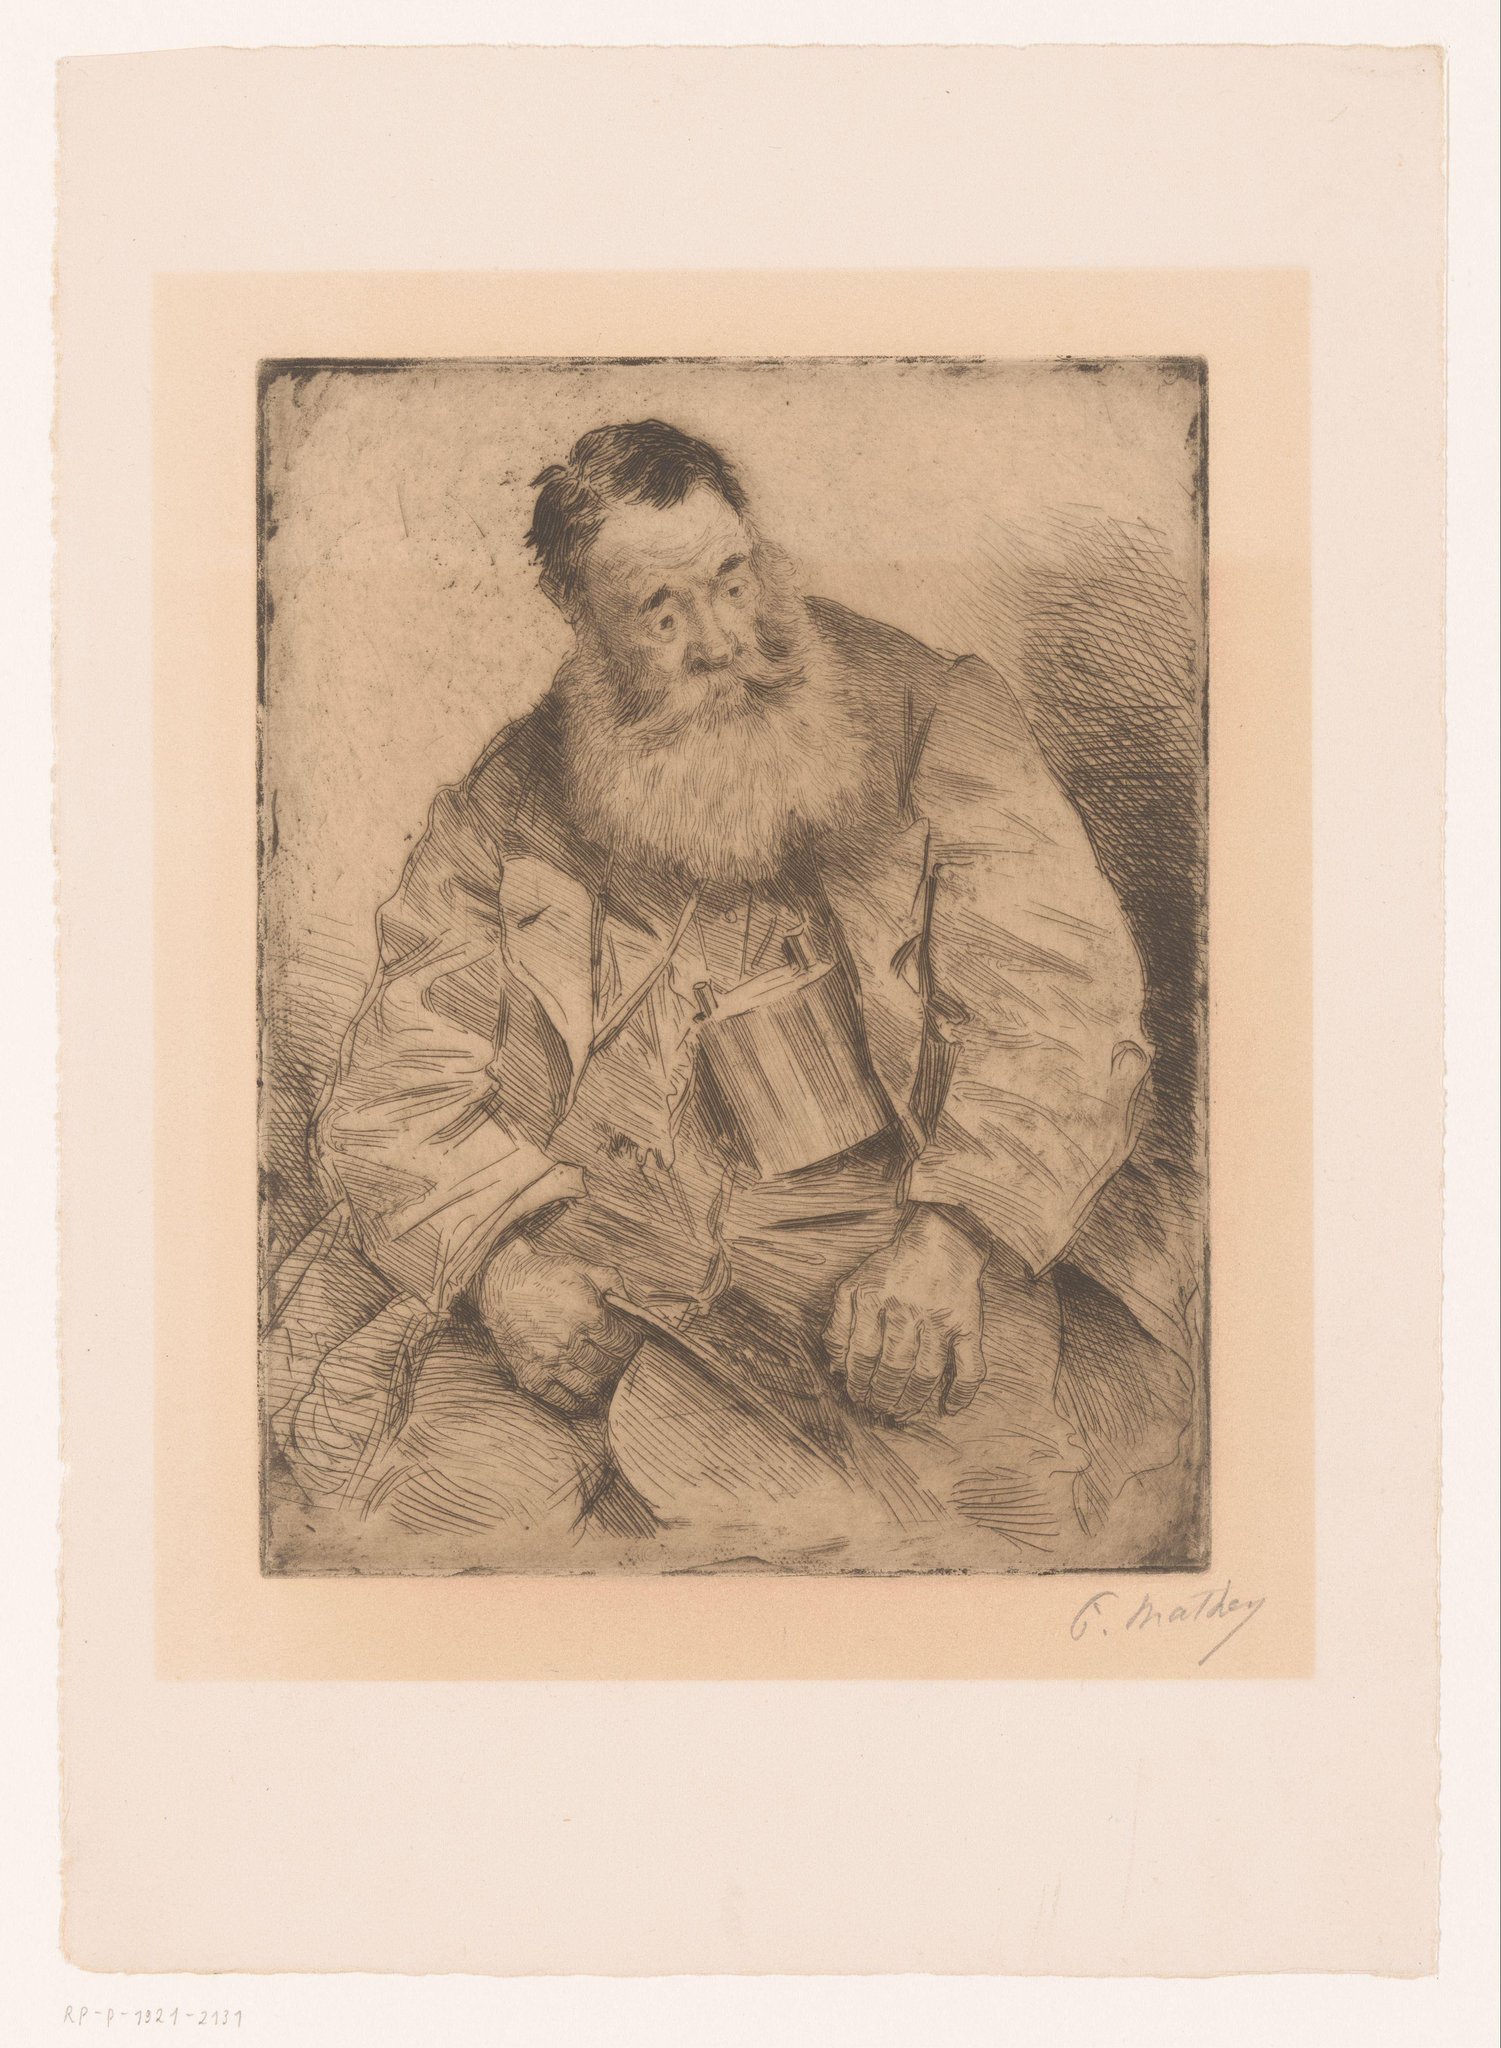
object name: print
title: Portret van een zittende man met baard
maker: paul mathey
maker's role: print maker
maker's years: 1844-1929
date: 1854-1921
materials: paper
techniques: drypoint, intaglio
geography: france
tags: sitting figure, historical persons, beard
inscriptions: collector's mark: Lugt 2228